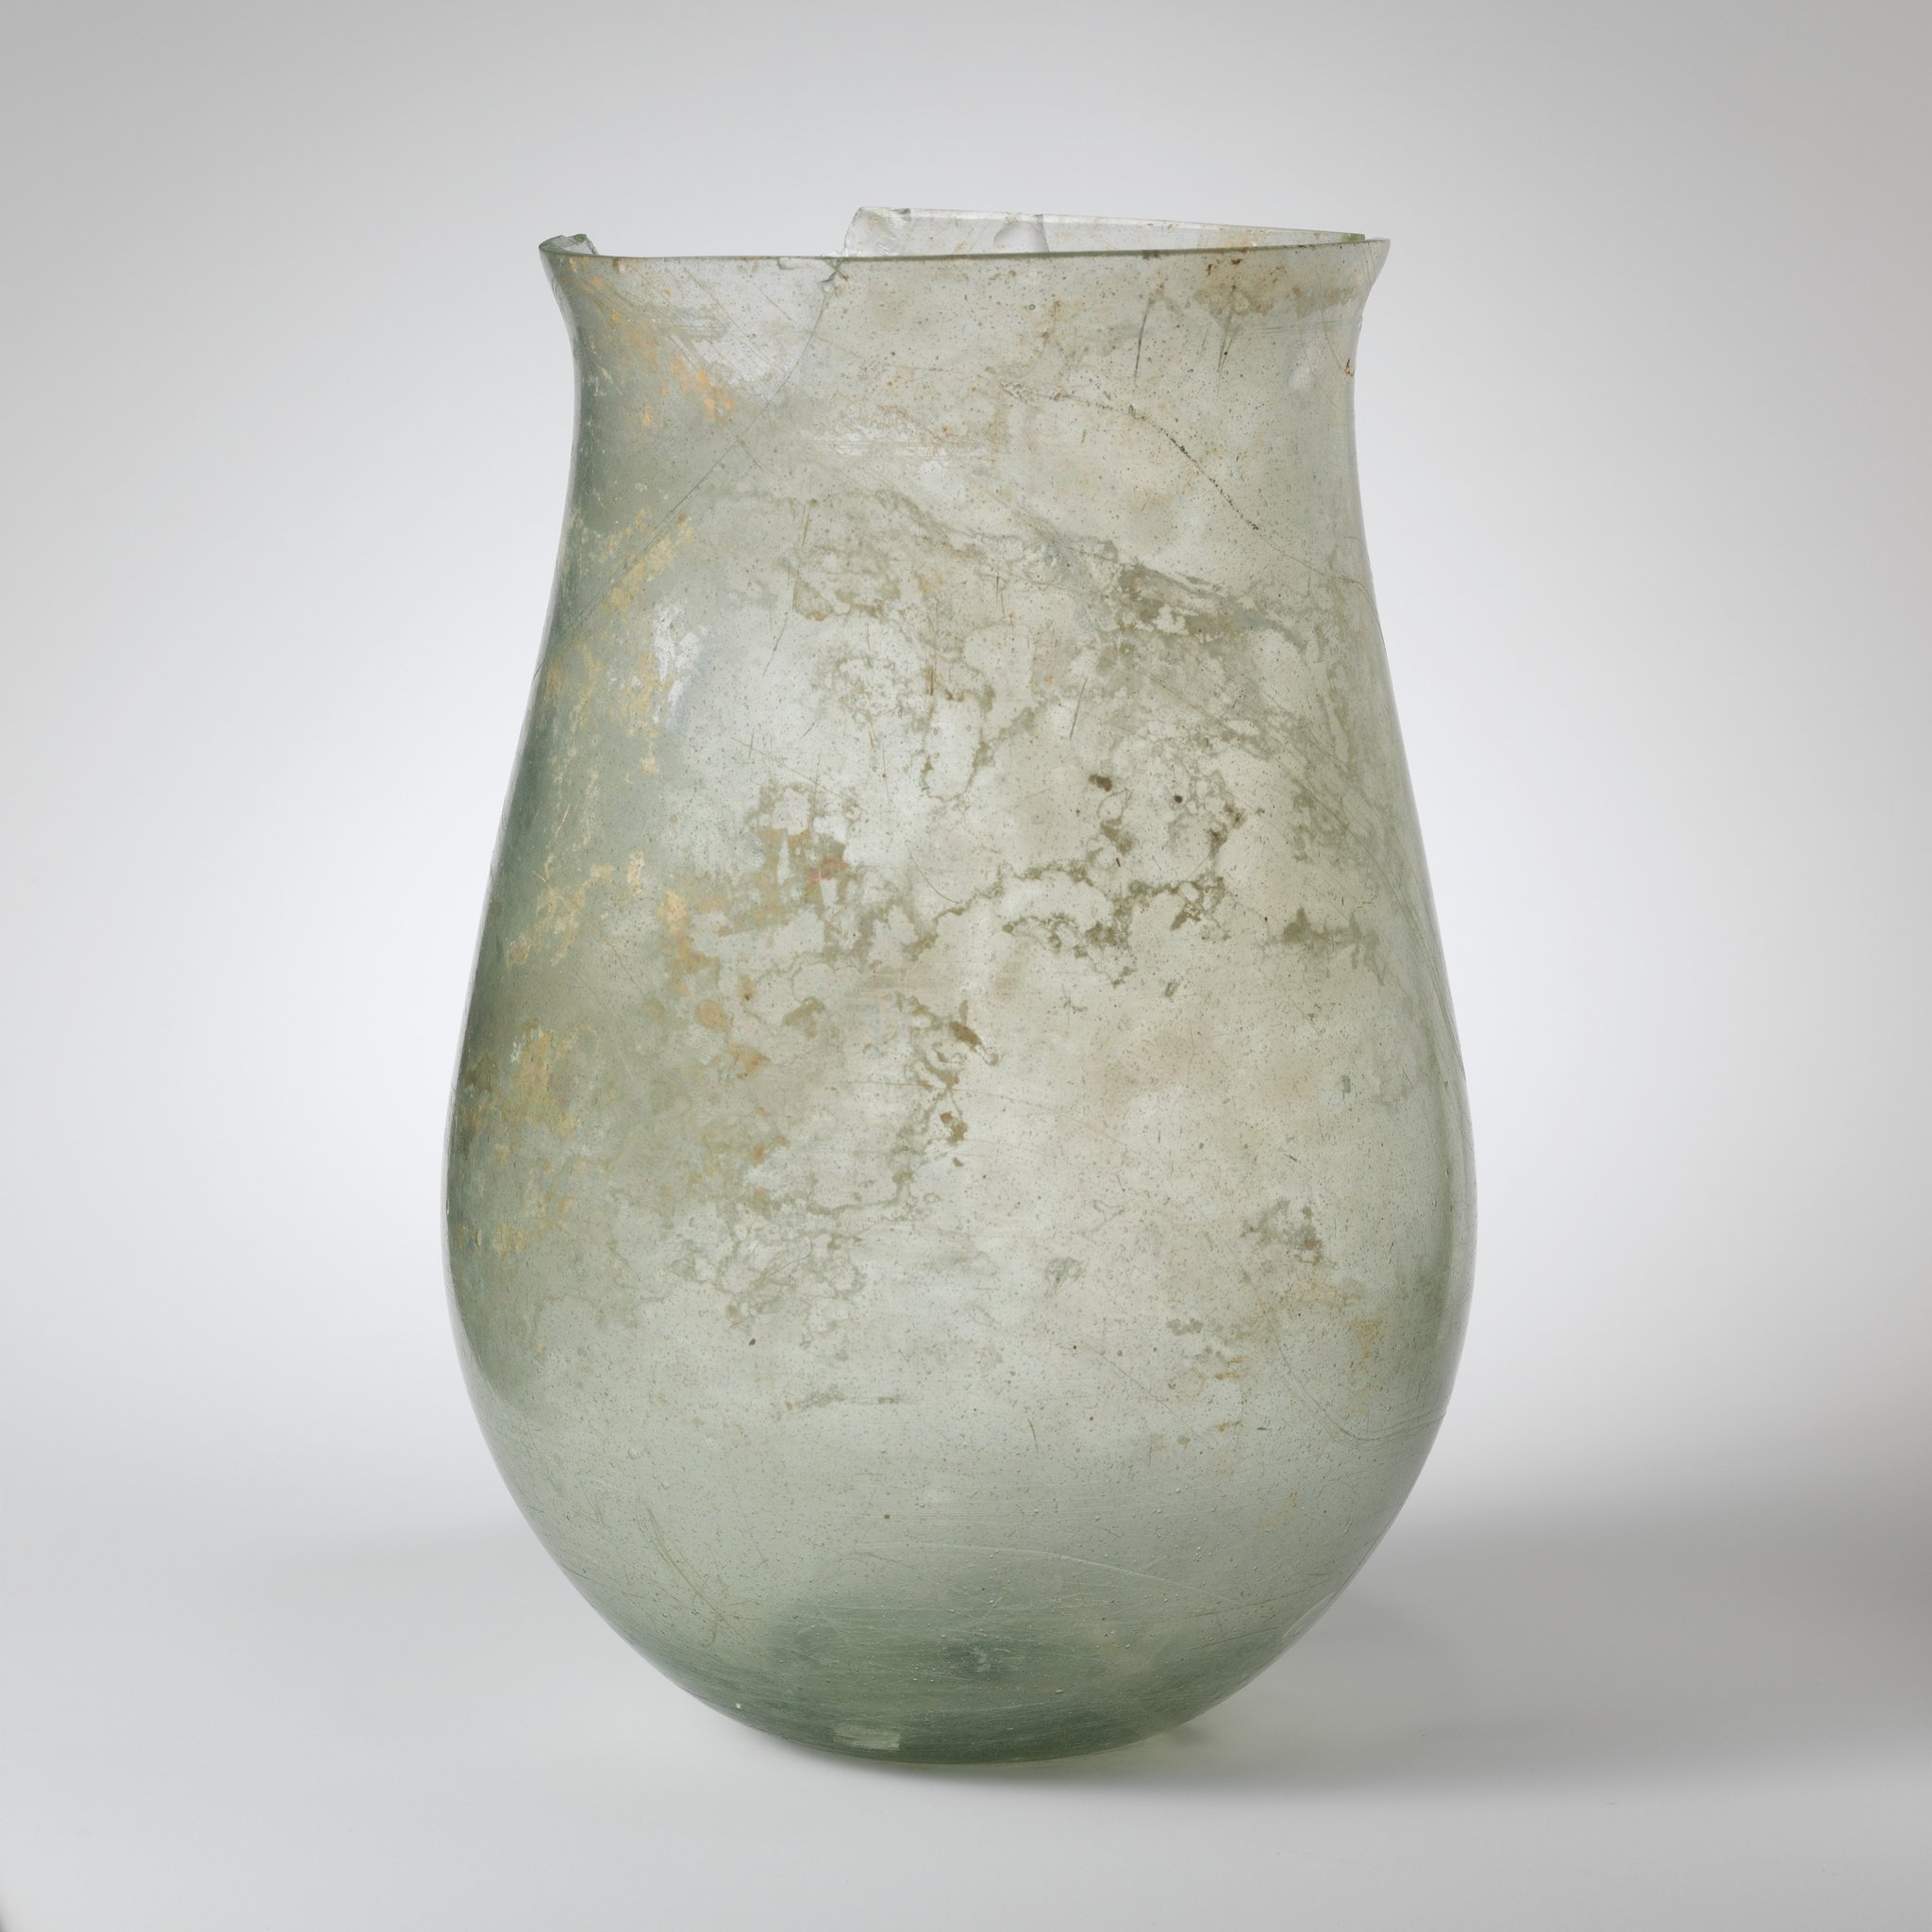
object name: urn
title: Glass jar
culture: roman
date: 1-300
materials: glass